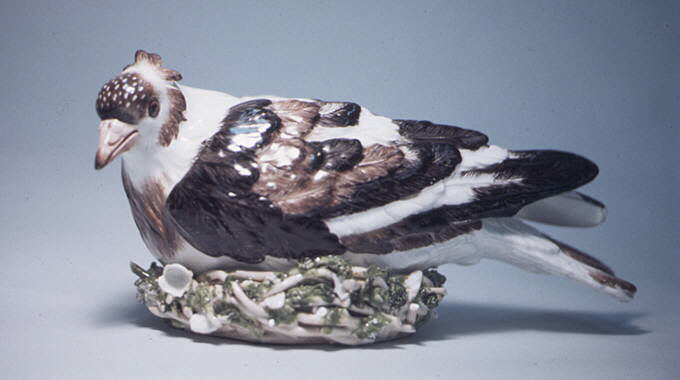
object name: figure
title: Nesting pigeon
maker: meissen manufactory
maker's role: manufactory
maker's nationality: german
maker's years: 1710-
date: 1732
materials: hard paste porcelain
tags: pigeons